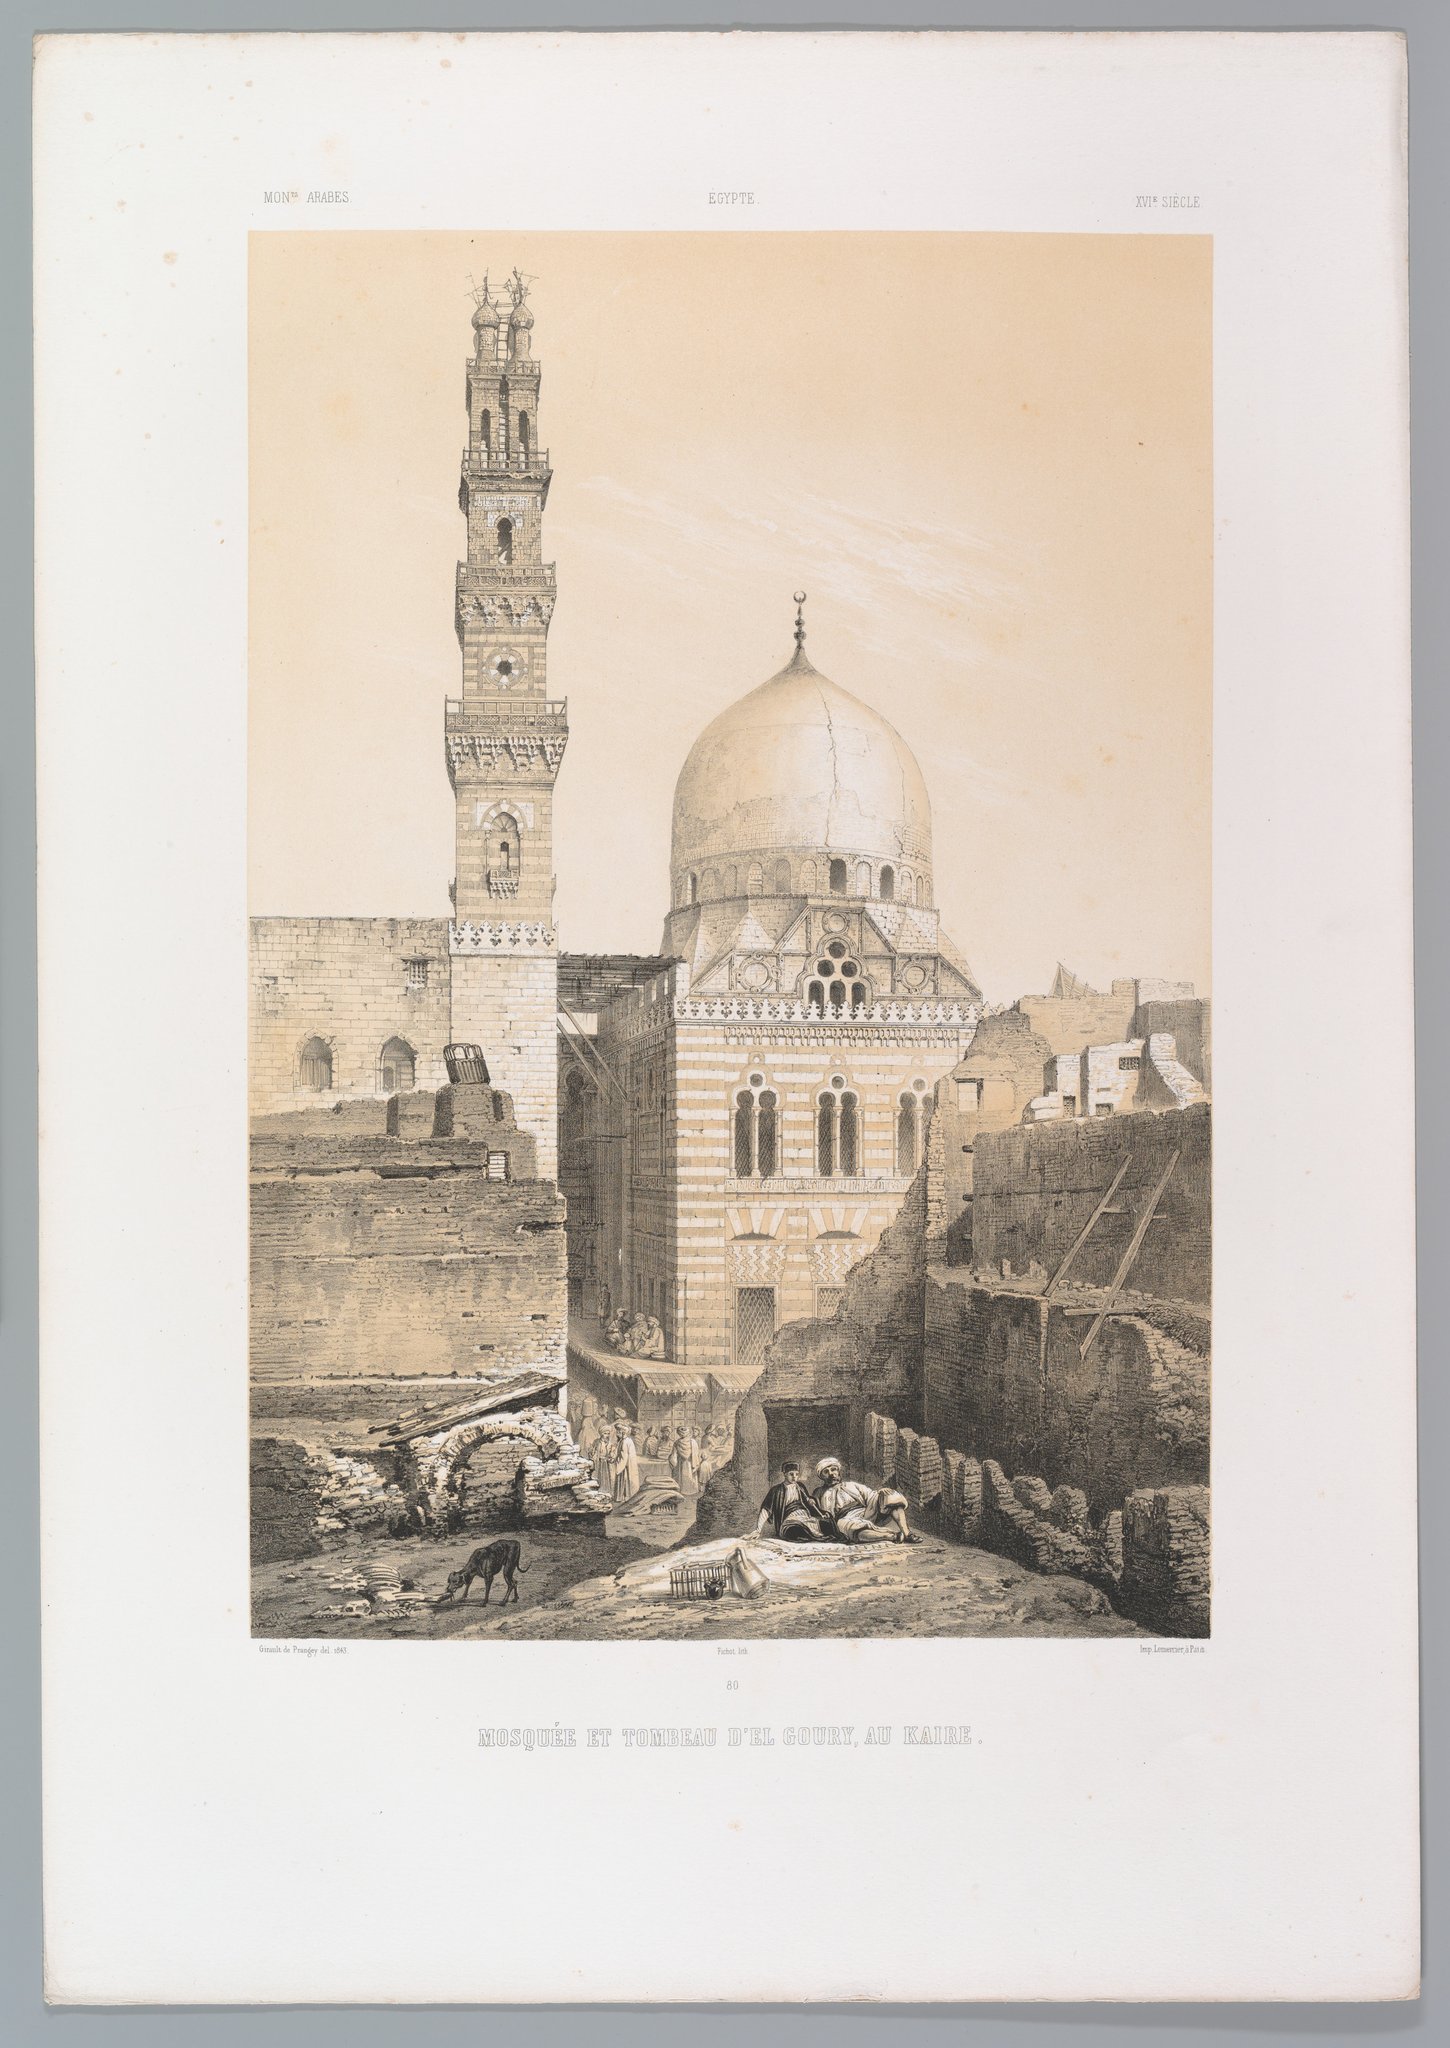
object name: lithograph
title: 80. Mosquée et Tombeau d’el Ghoûry, au Kaire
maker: joseph-philibert girault de prangey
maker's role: artist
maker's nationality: french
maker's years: 1804-1892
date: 1843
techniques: lithograph